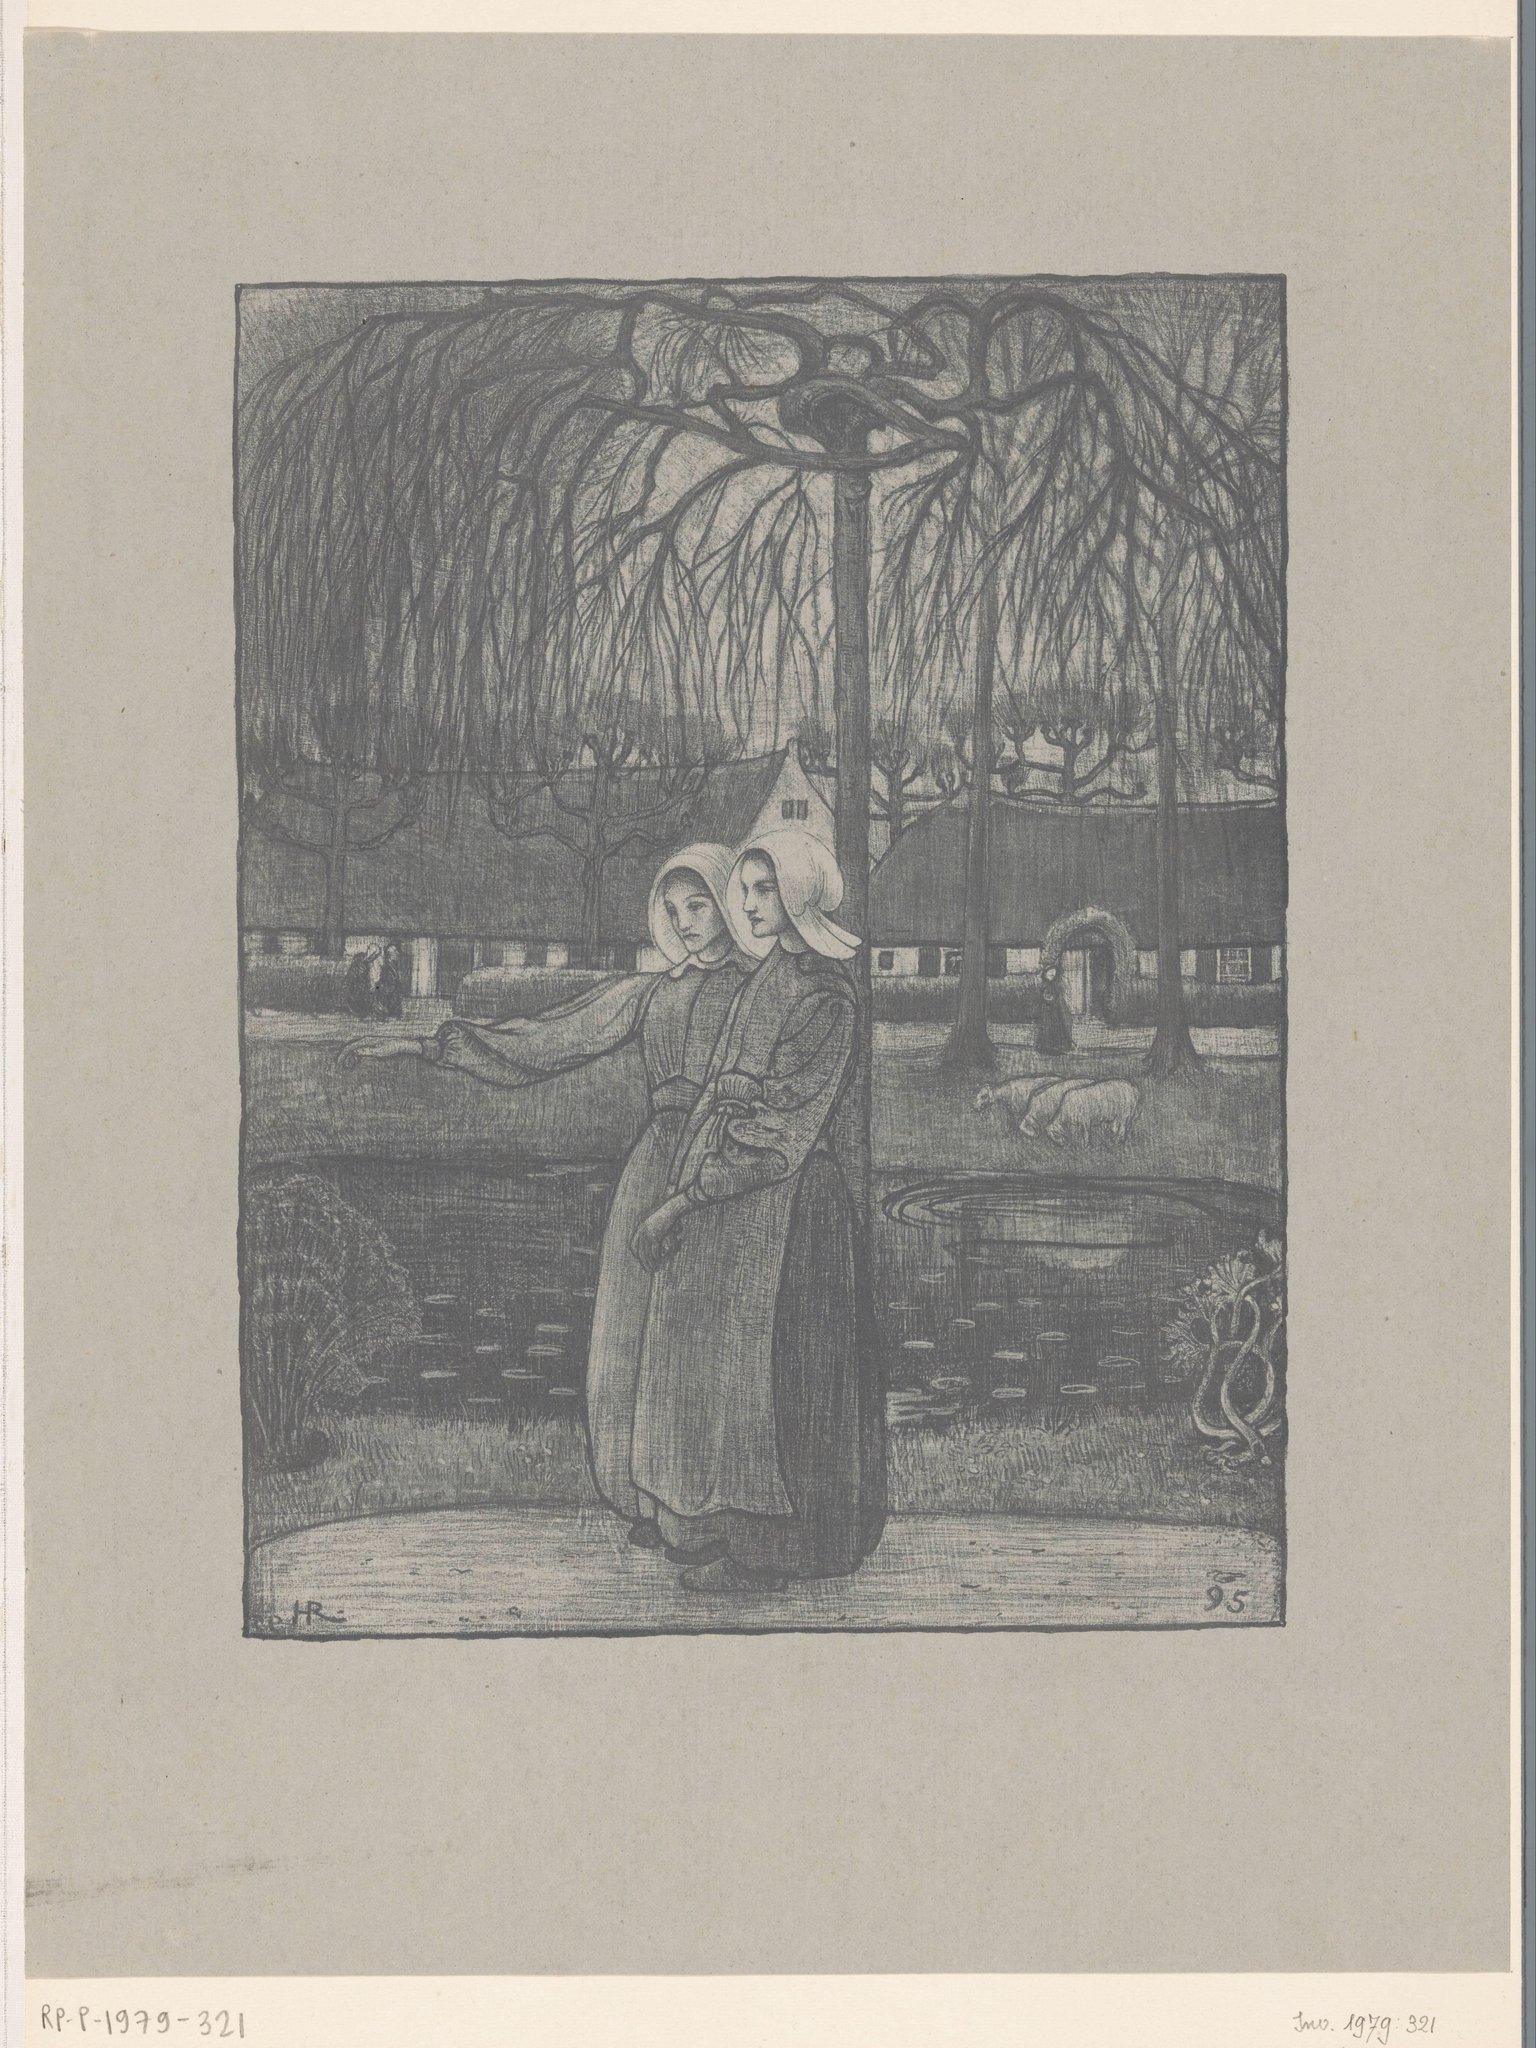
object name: print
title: Huizer meisjes bij een vijver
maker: richard nicolaüs roland holst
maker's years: 1868-1938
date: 1895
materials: paper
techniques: lithograph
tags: trees (+ bare plant), village, pond, pool, folk costume, regional costume, child (at home) - aa - girl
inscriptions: collector's mark: Lugt 2228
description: Achter de meisjes een boom met kale takken. Op de achtergrond drie grazende schapen en twee huizen.